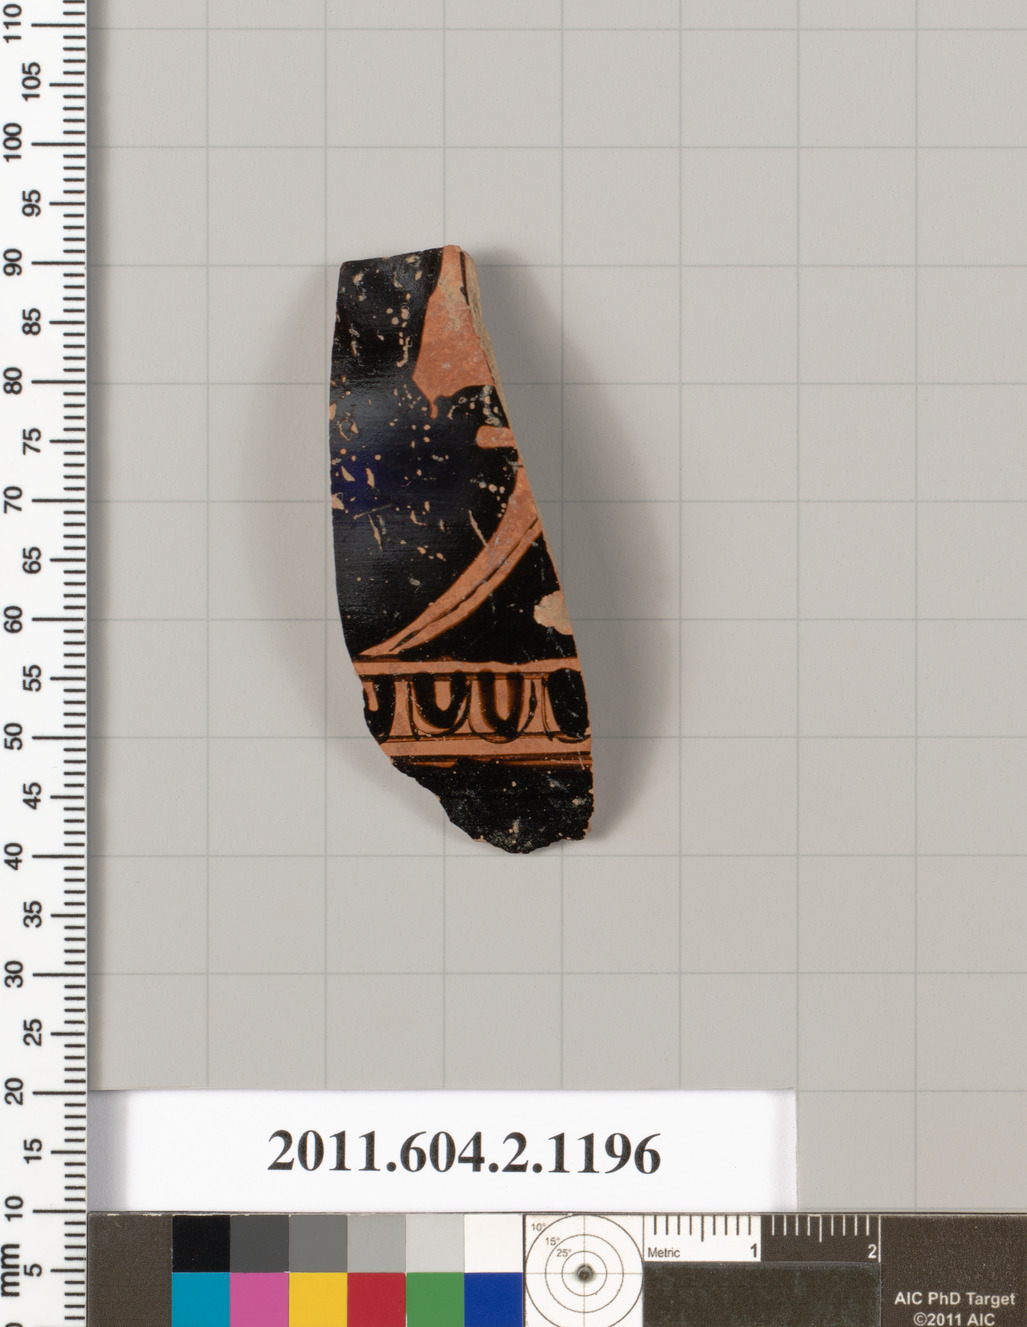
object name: lekythos fragment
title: Terracotta fragment of a squat lekythos (oil flask)?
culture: greek, attic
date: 450-401 BCE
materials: terracotta